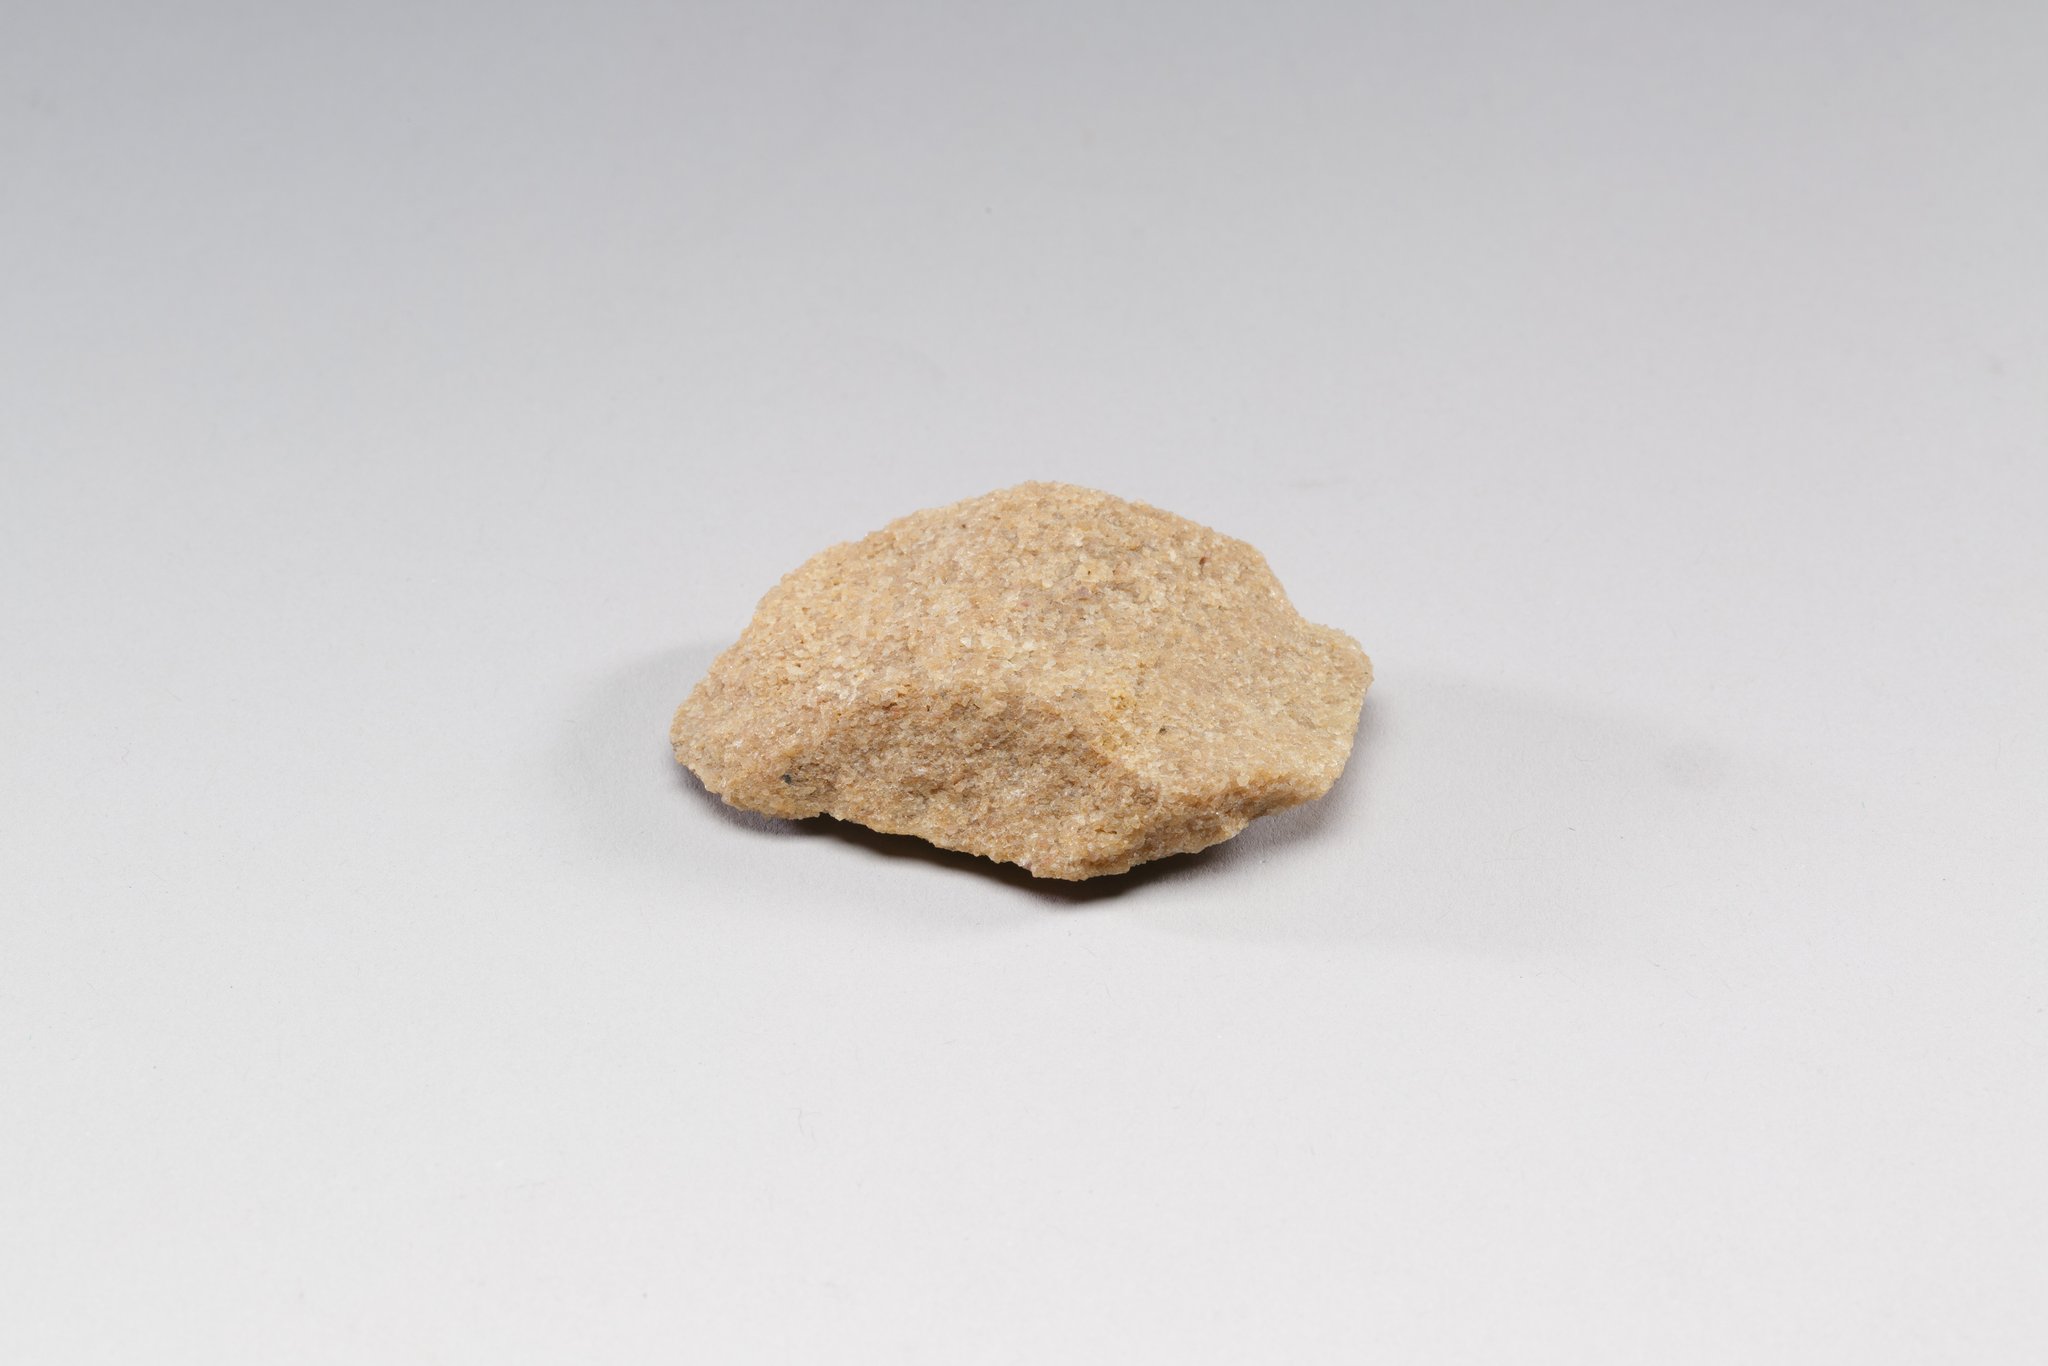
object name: rubbing stone, tool, senenmut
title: Rubbing Stone (?)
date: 1479-1458 BCE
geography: egypt